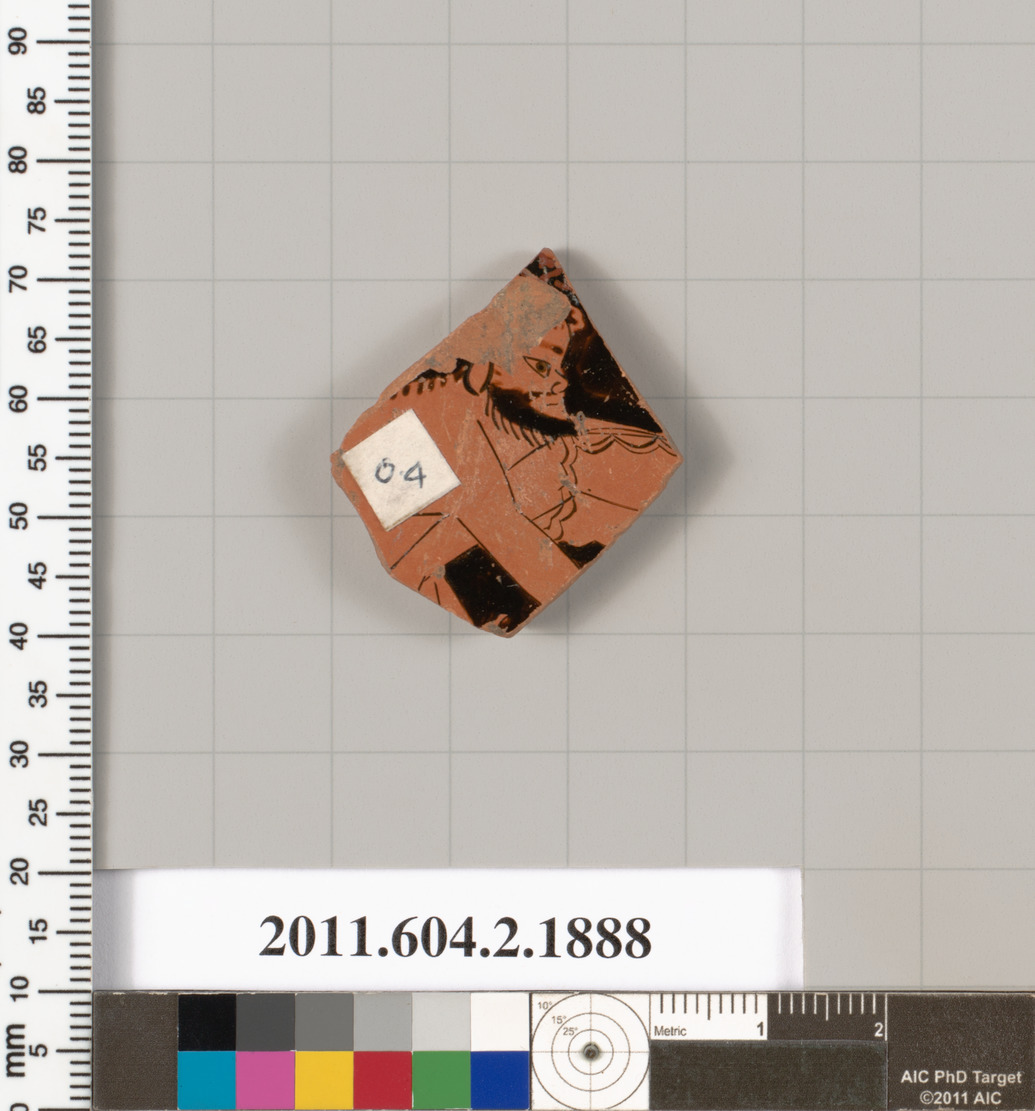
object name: skyphos fragment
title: Terracotta fragment of a skyphos (deep drinking cup)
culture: greek, attic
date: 500-490 BCE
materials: terracotta